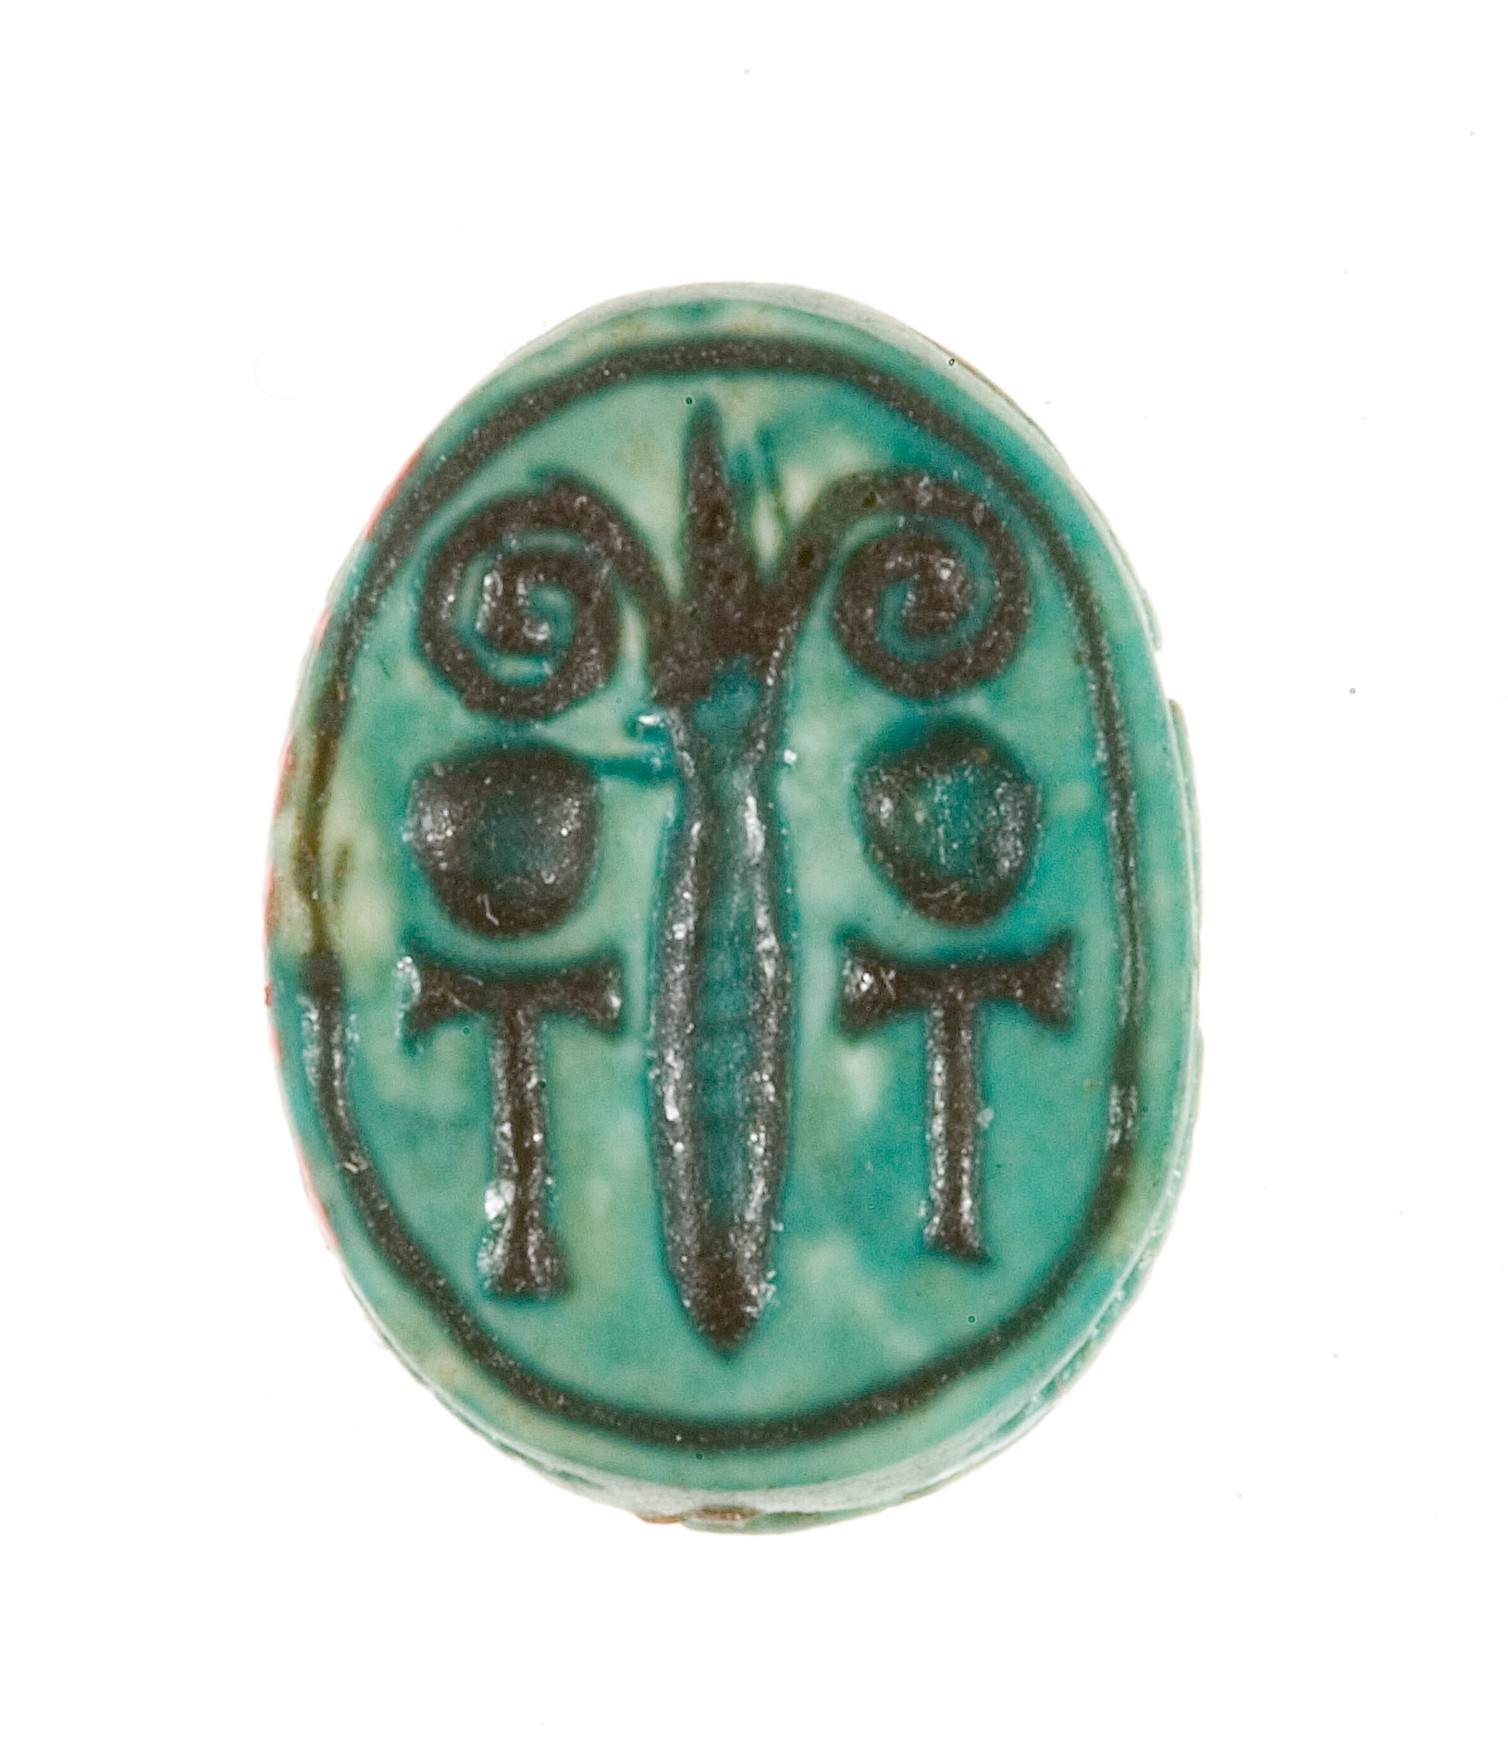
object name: scarab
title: Scarab Inscribed with a Hieroglyphic Motif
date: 1479-1458 BCE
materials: stone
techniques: glazing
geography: egypt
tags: hieroglyphs,scarabs